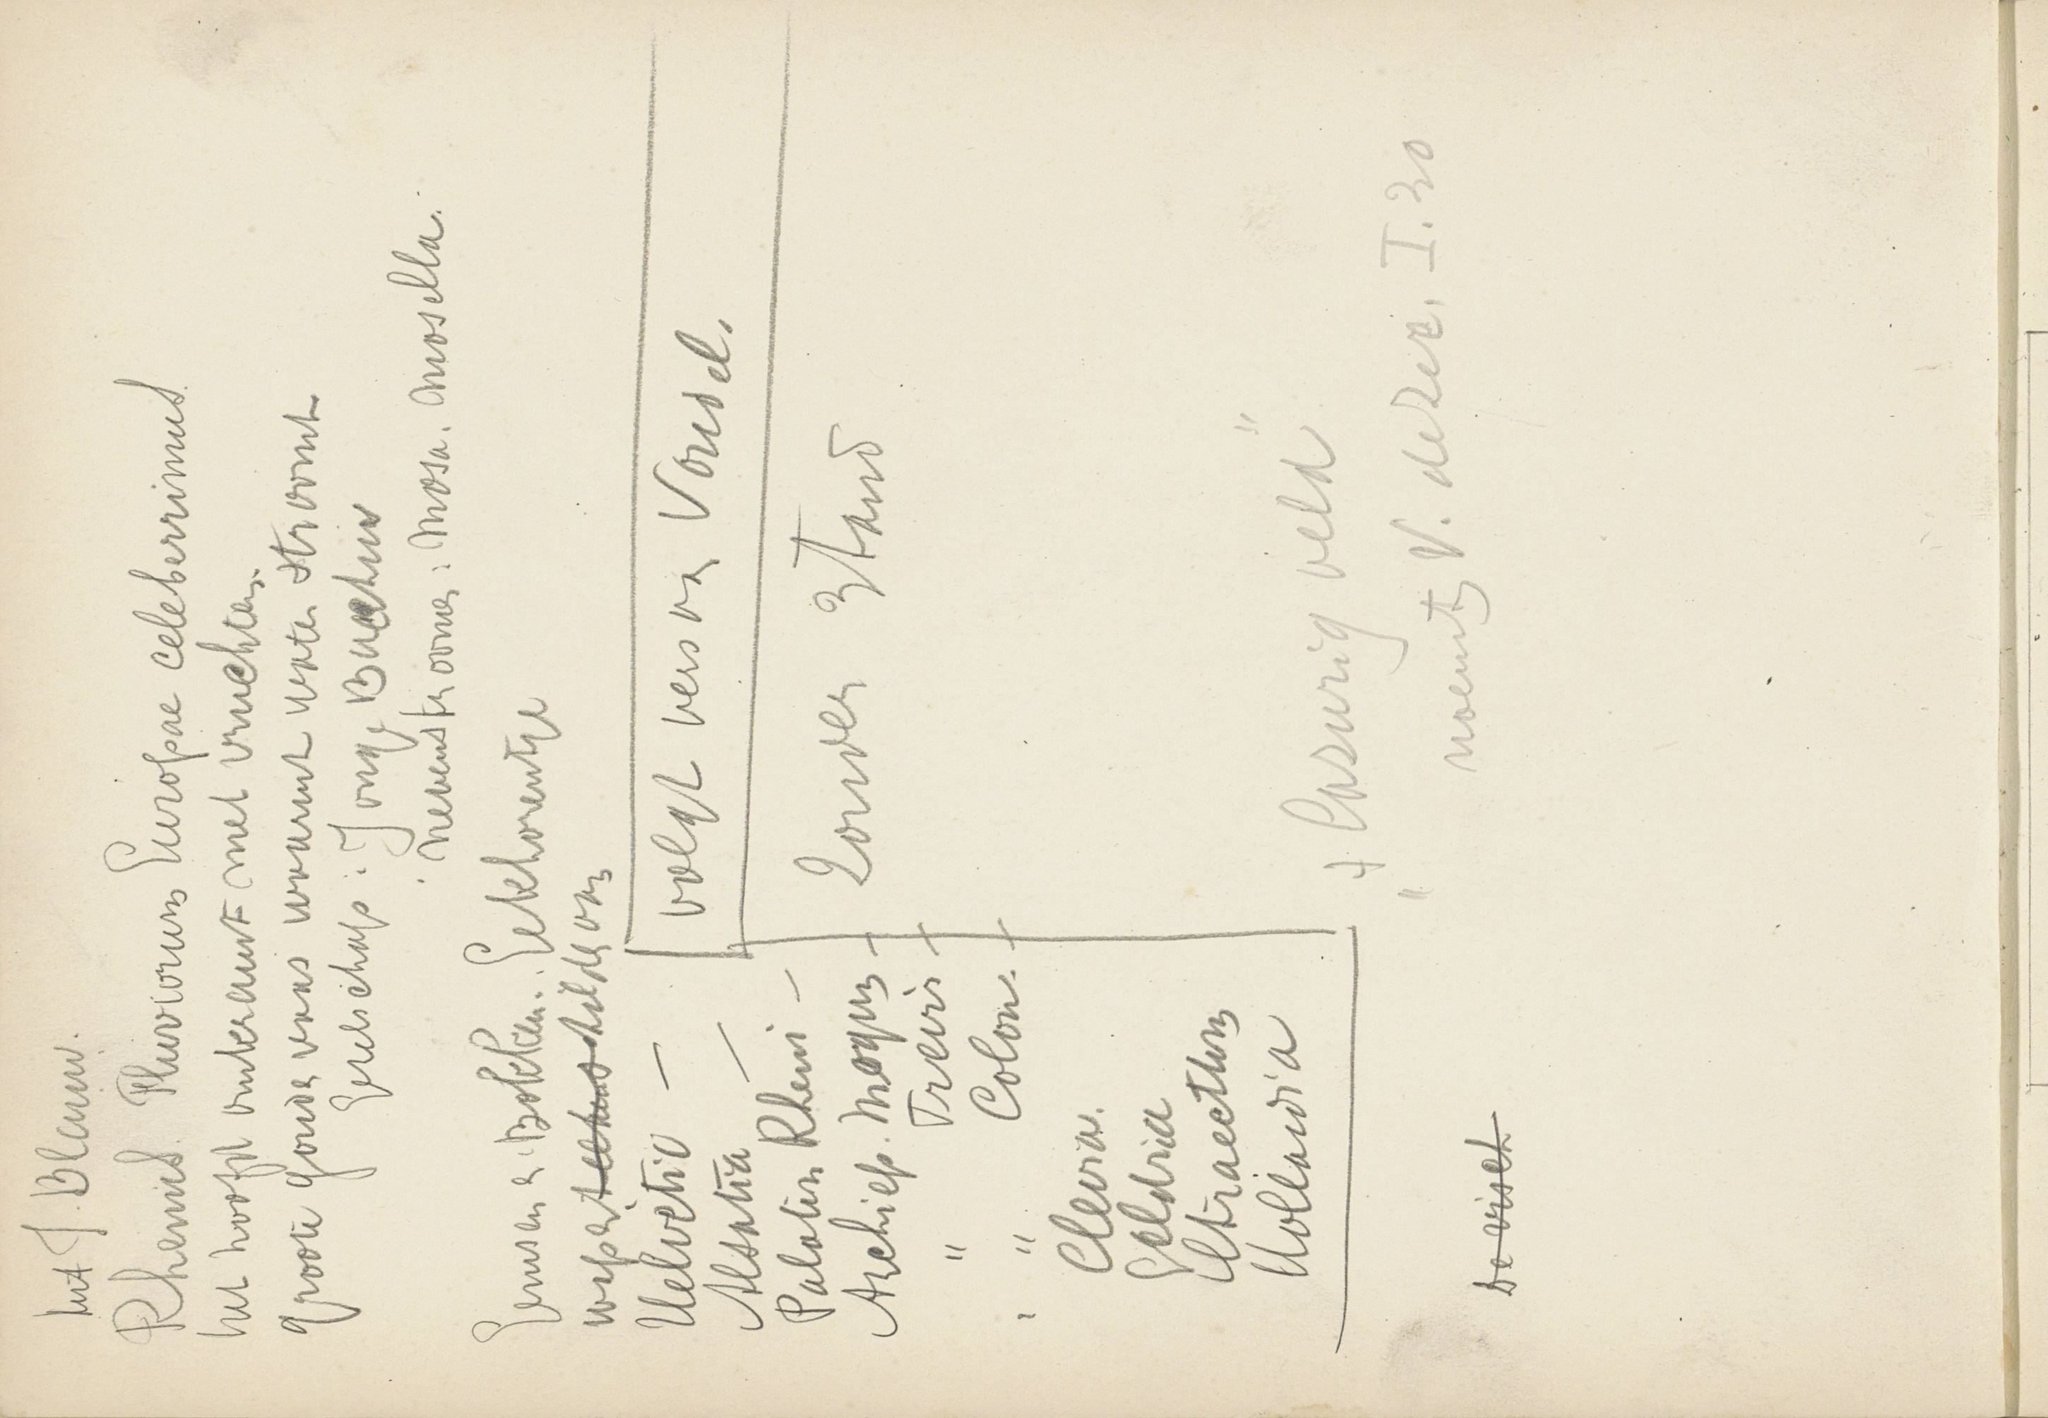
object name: sketchbook leaf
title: Notities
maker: antoon derkinderen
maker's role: draughtsman, painter, print maker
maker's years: 1859-1925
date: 1900-1903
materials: paper, pencil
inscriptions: annotation: ‘uit J. Blauw./ 'Rhenvs Fluviorum Europae celeberrimus/ [...]’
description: Blad 27 verso uit een schetsboek met 45 bladen.